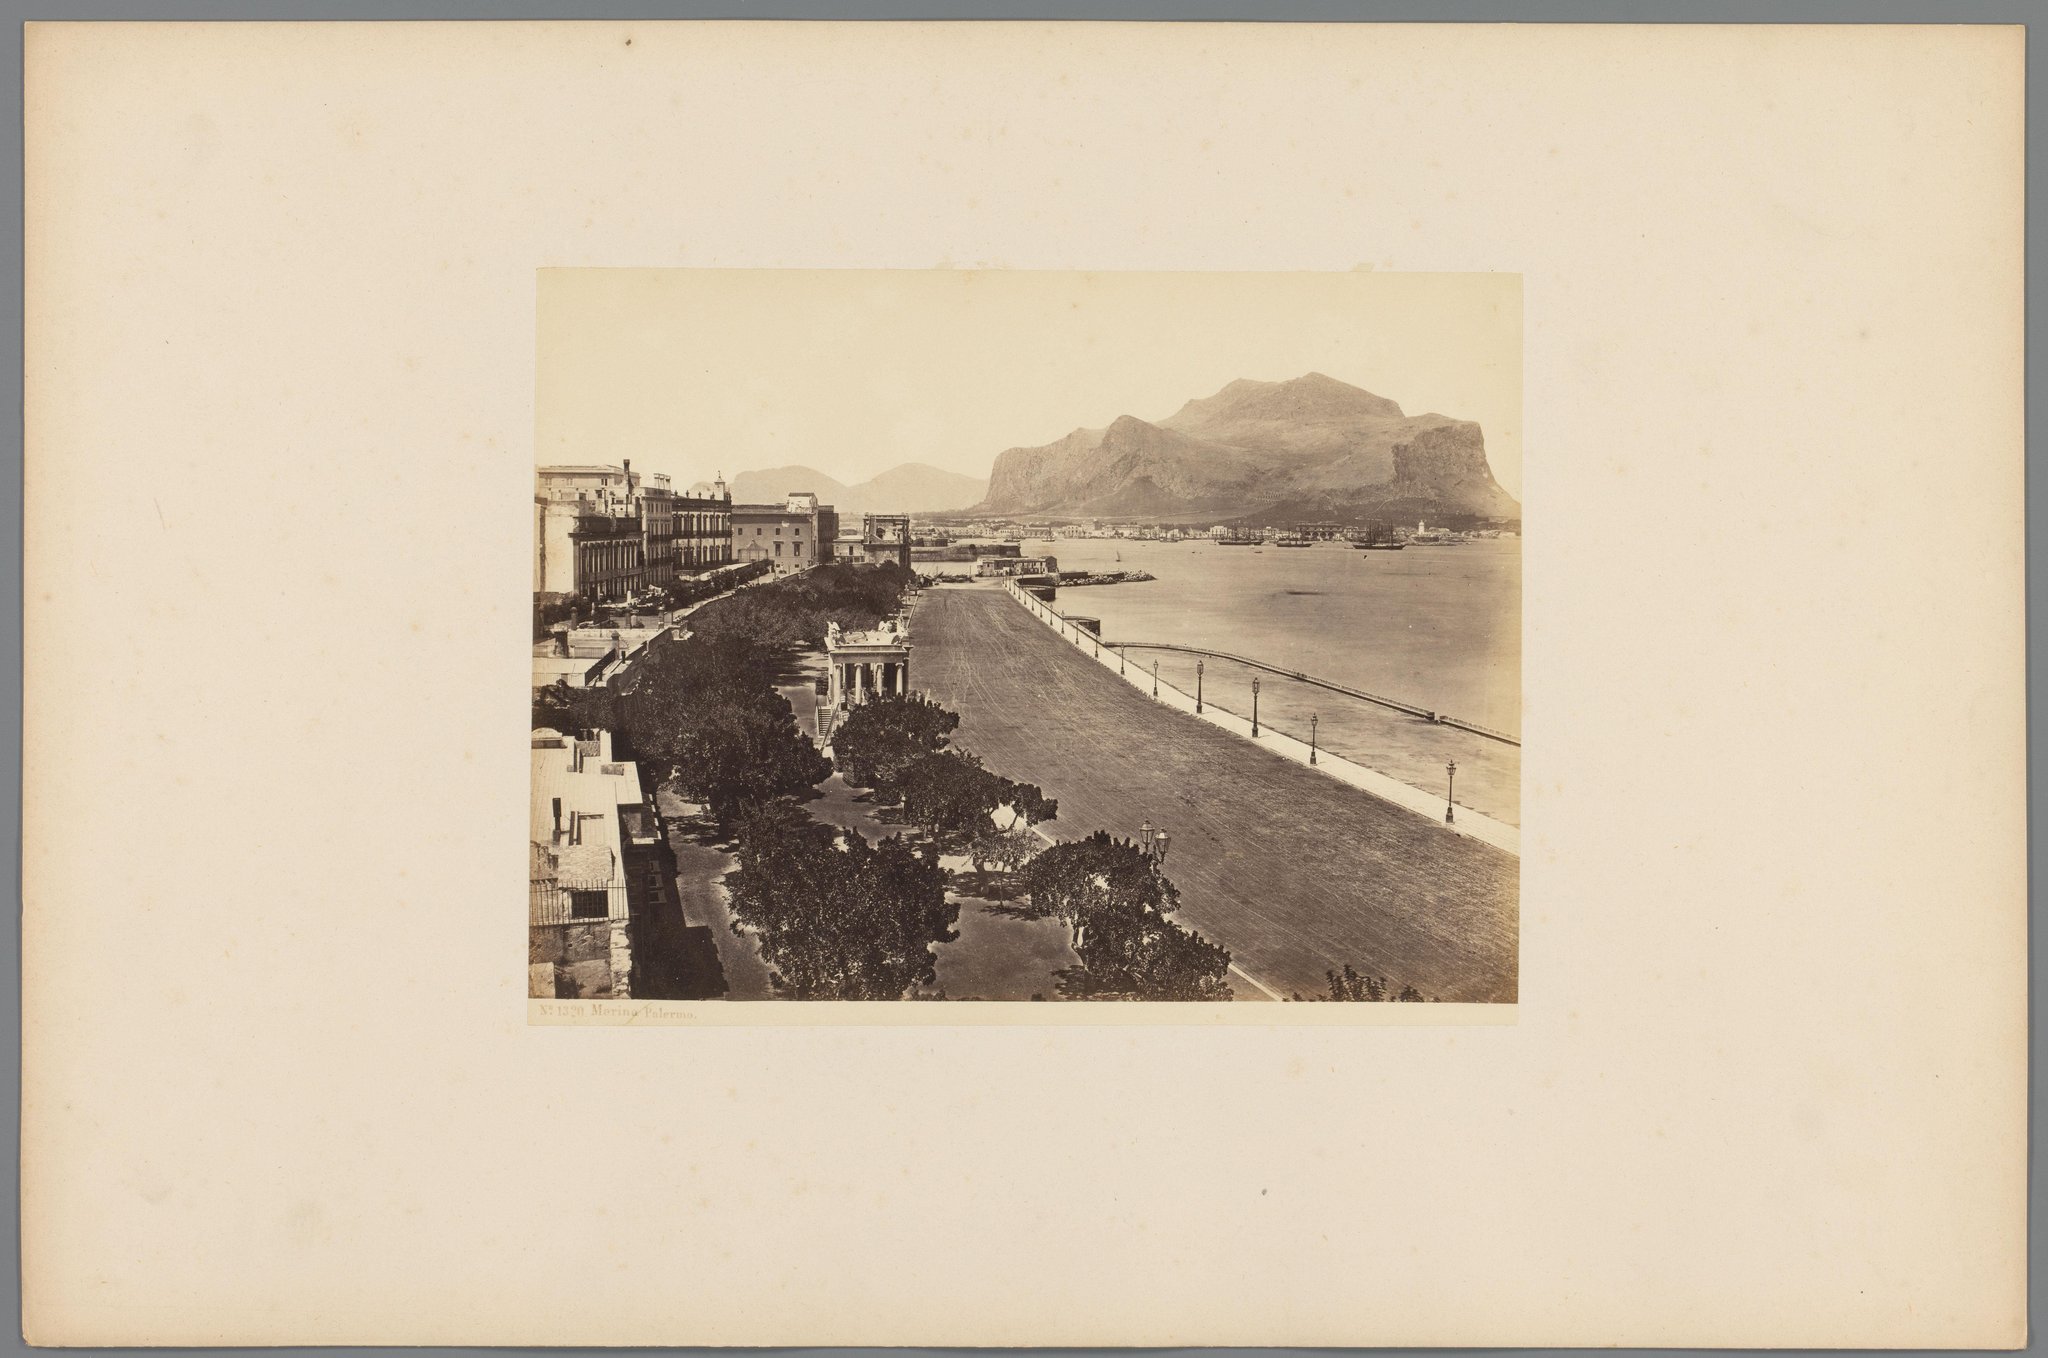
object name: photograph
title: Marina Palermo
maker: Anonymous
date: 1851-1900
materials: cardboard, paper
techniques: albumen print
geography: palermo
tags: gulf, bay, quay, mountains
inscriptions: number: ‘No. 1320’